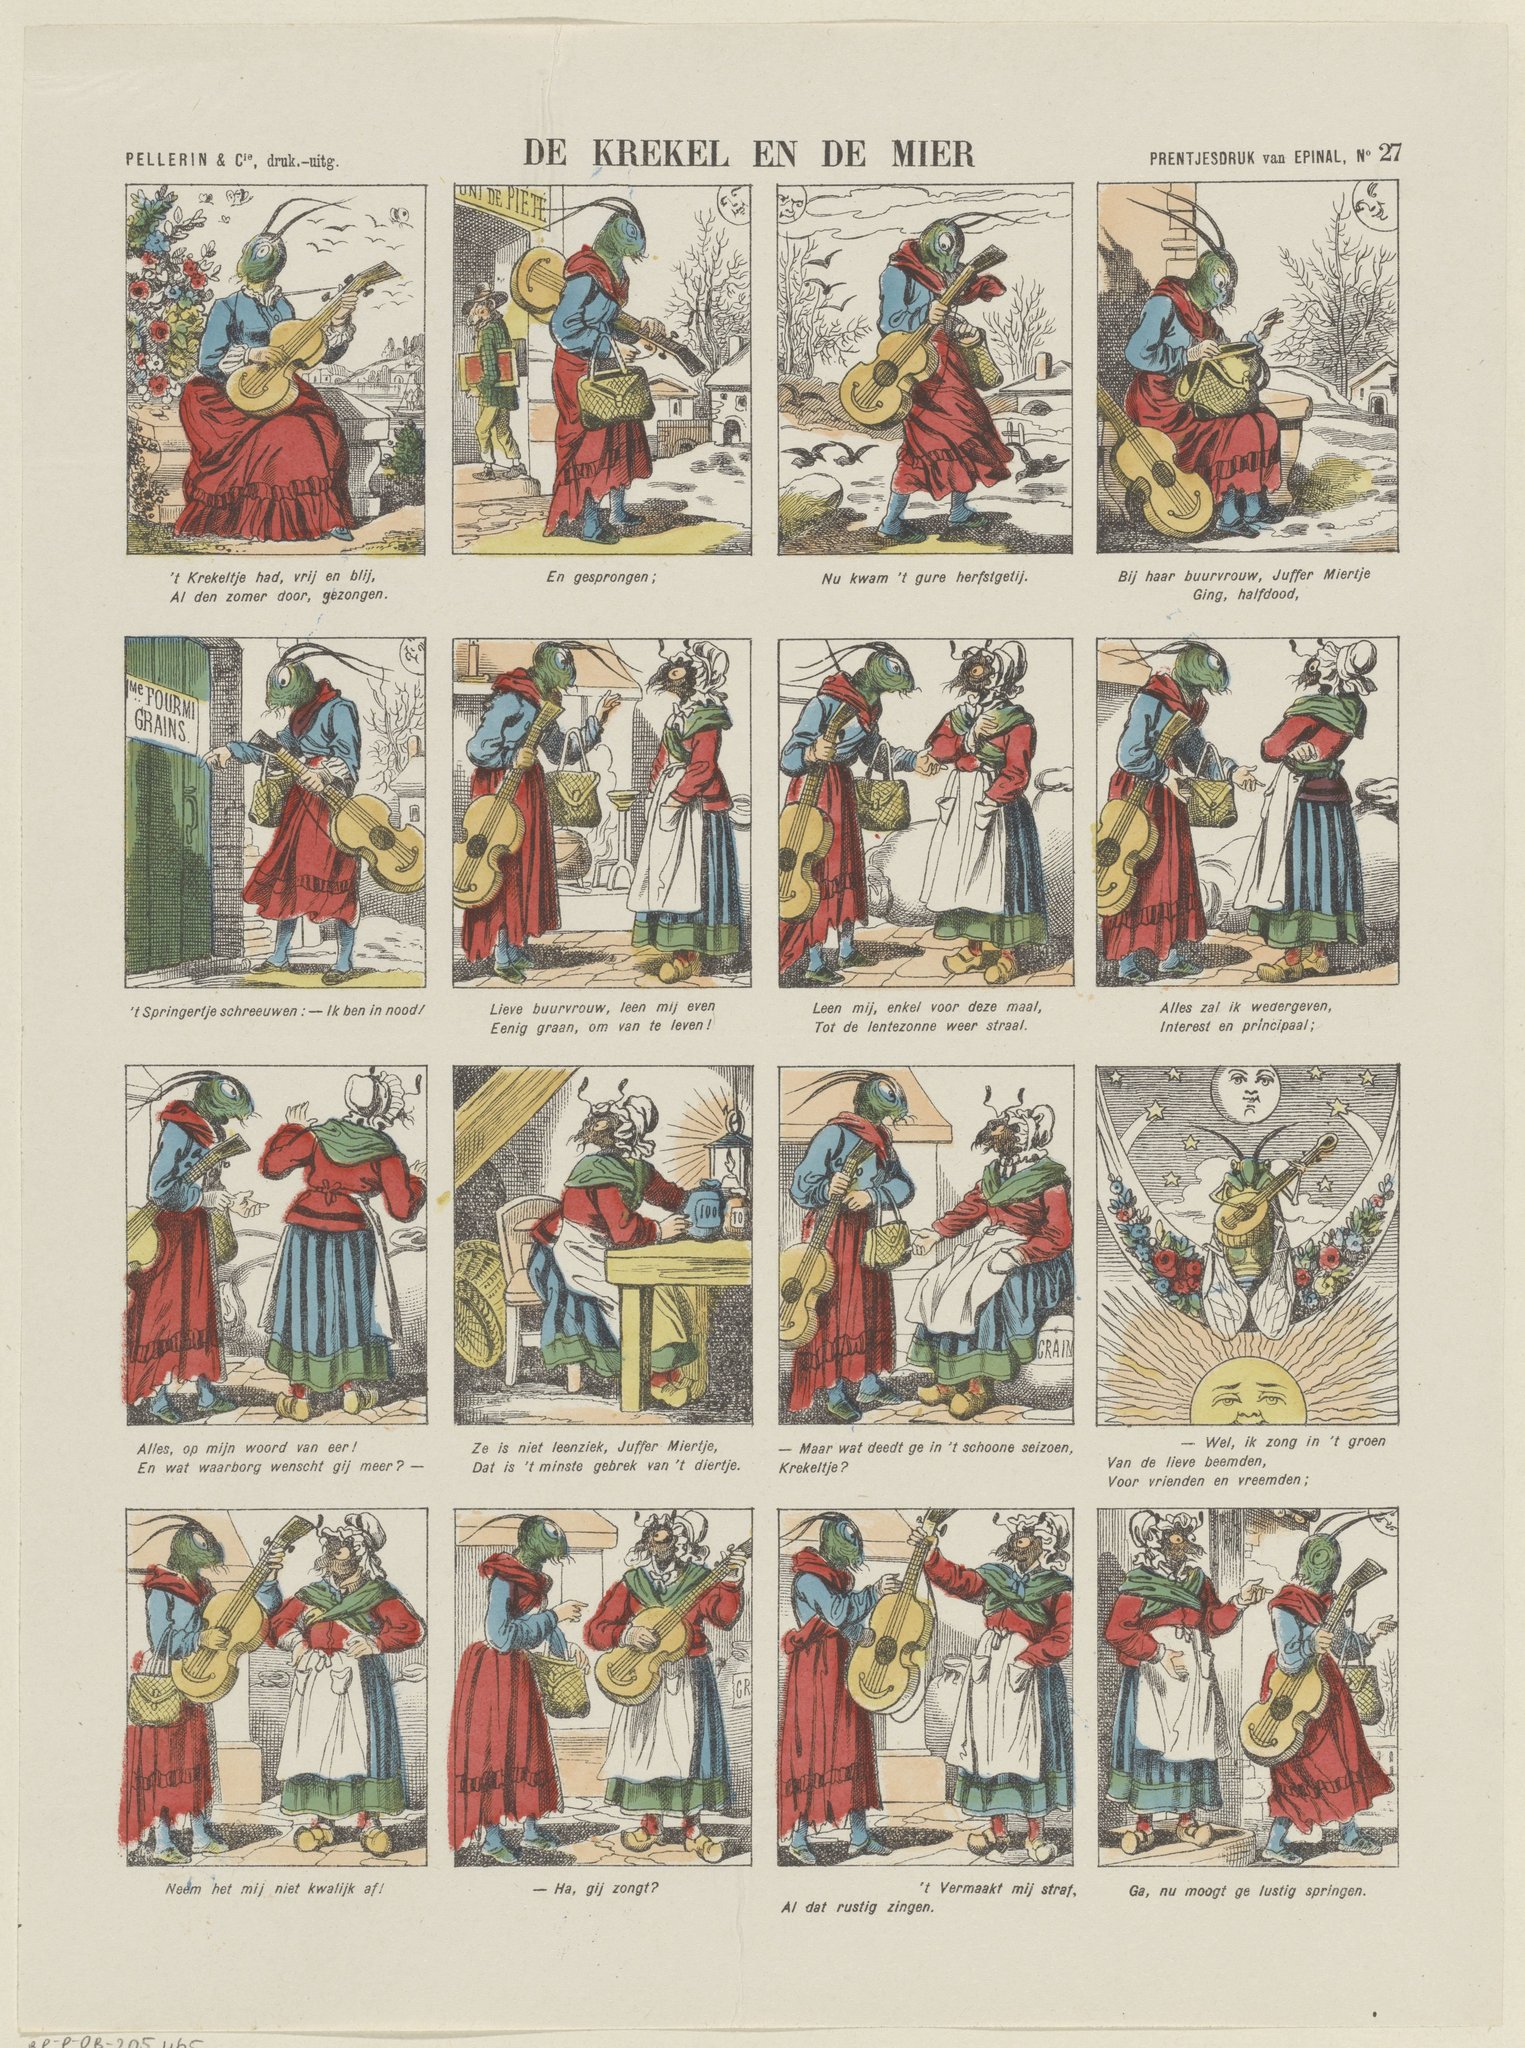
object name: print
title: Prentjesdruk van Épinal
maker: Anonymous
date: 1902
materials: paper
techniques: colour, letterpress printing, lithograph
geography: epinal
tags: insects: ant, animals acting as human beings, fables, insects: cricket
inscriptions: collector's mark: Lugt 2760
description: Blad met 16 voorstellingen uit de fabel van de krekel en de mier. Onder elke afbeelding een onderschrift. Genummerd rechtsboven: No 27.